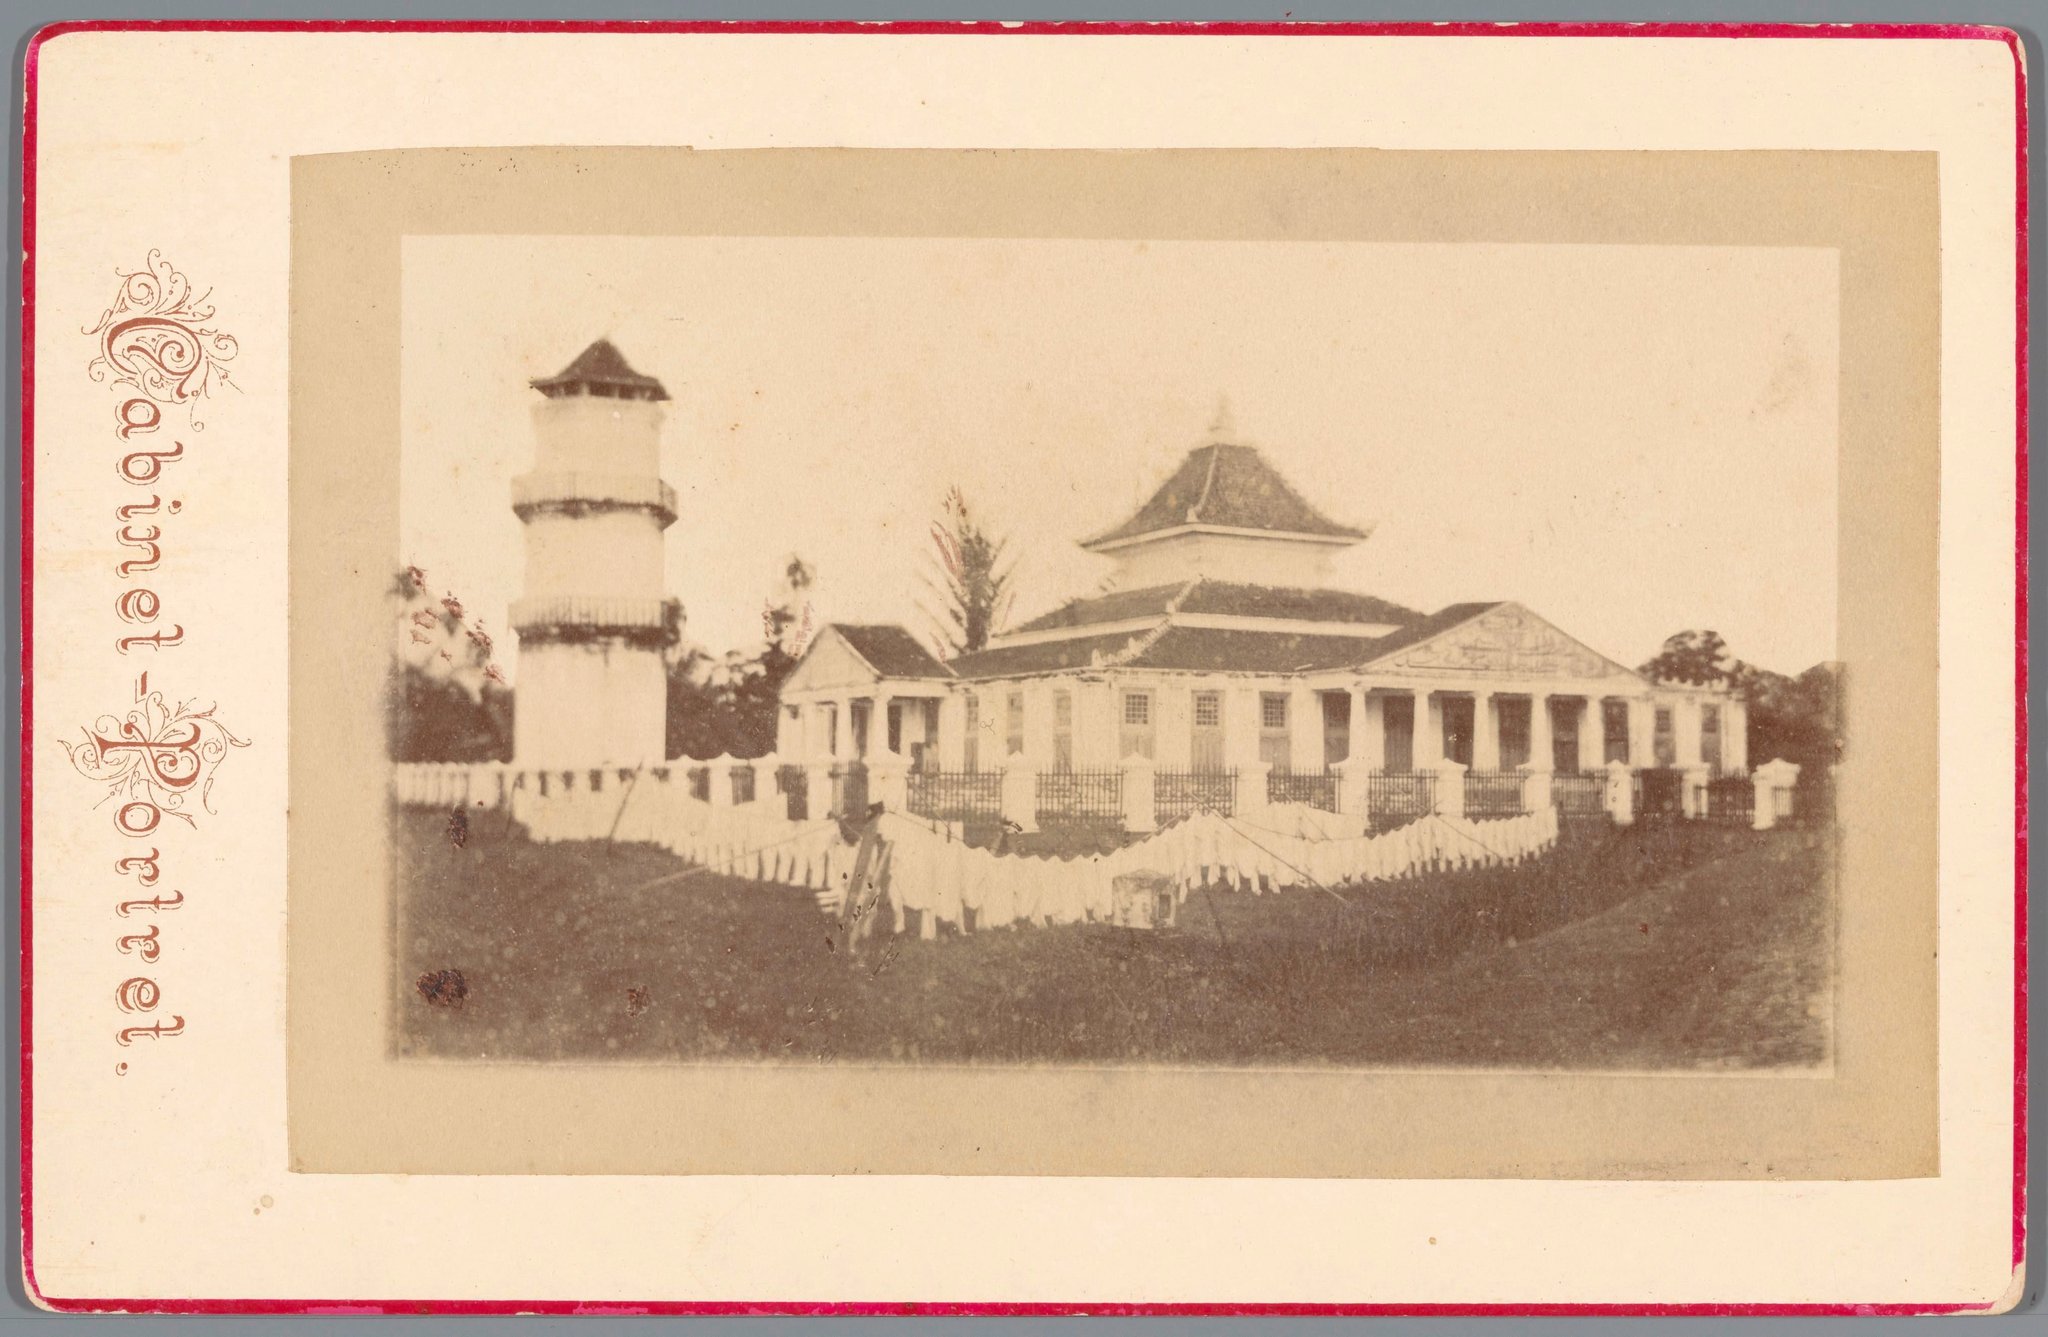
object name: cabinet photograph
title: Palembang. Missigit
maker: Anonymous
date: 1890-1910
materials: cardboard, paper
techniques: albumen print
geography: palembang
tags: temple, shrine ~ islam, mohammedanism, palembang (city)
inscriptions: inscription: ‘Cabinet-Portret’